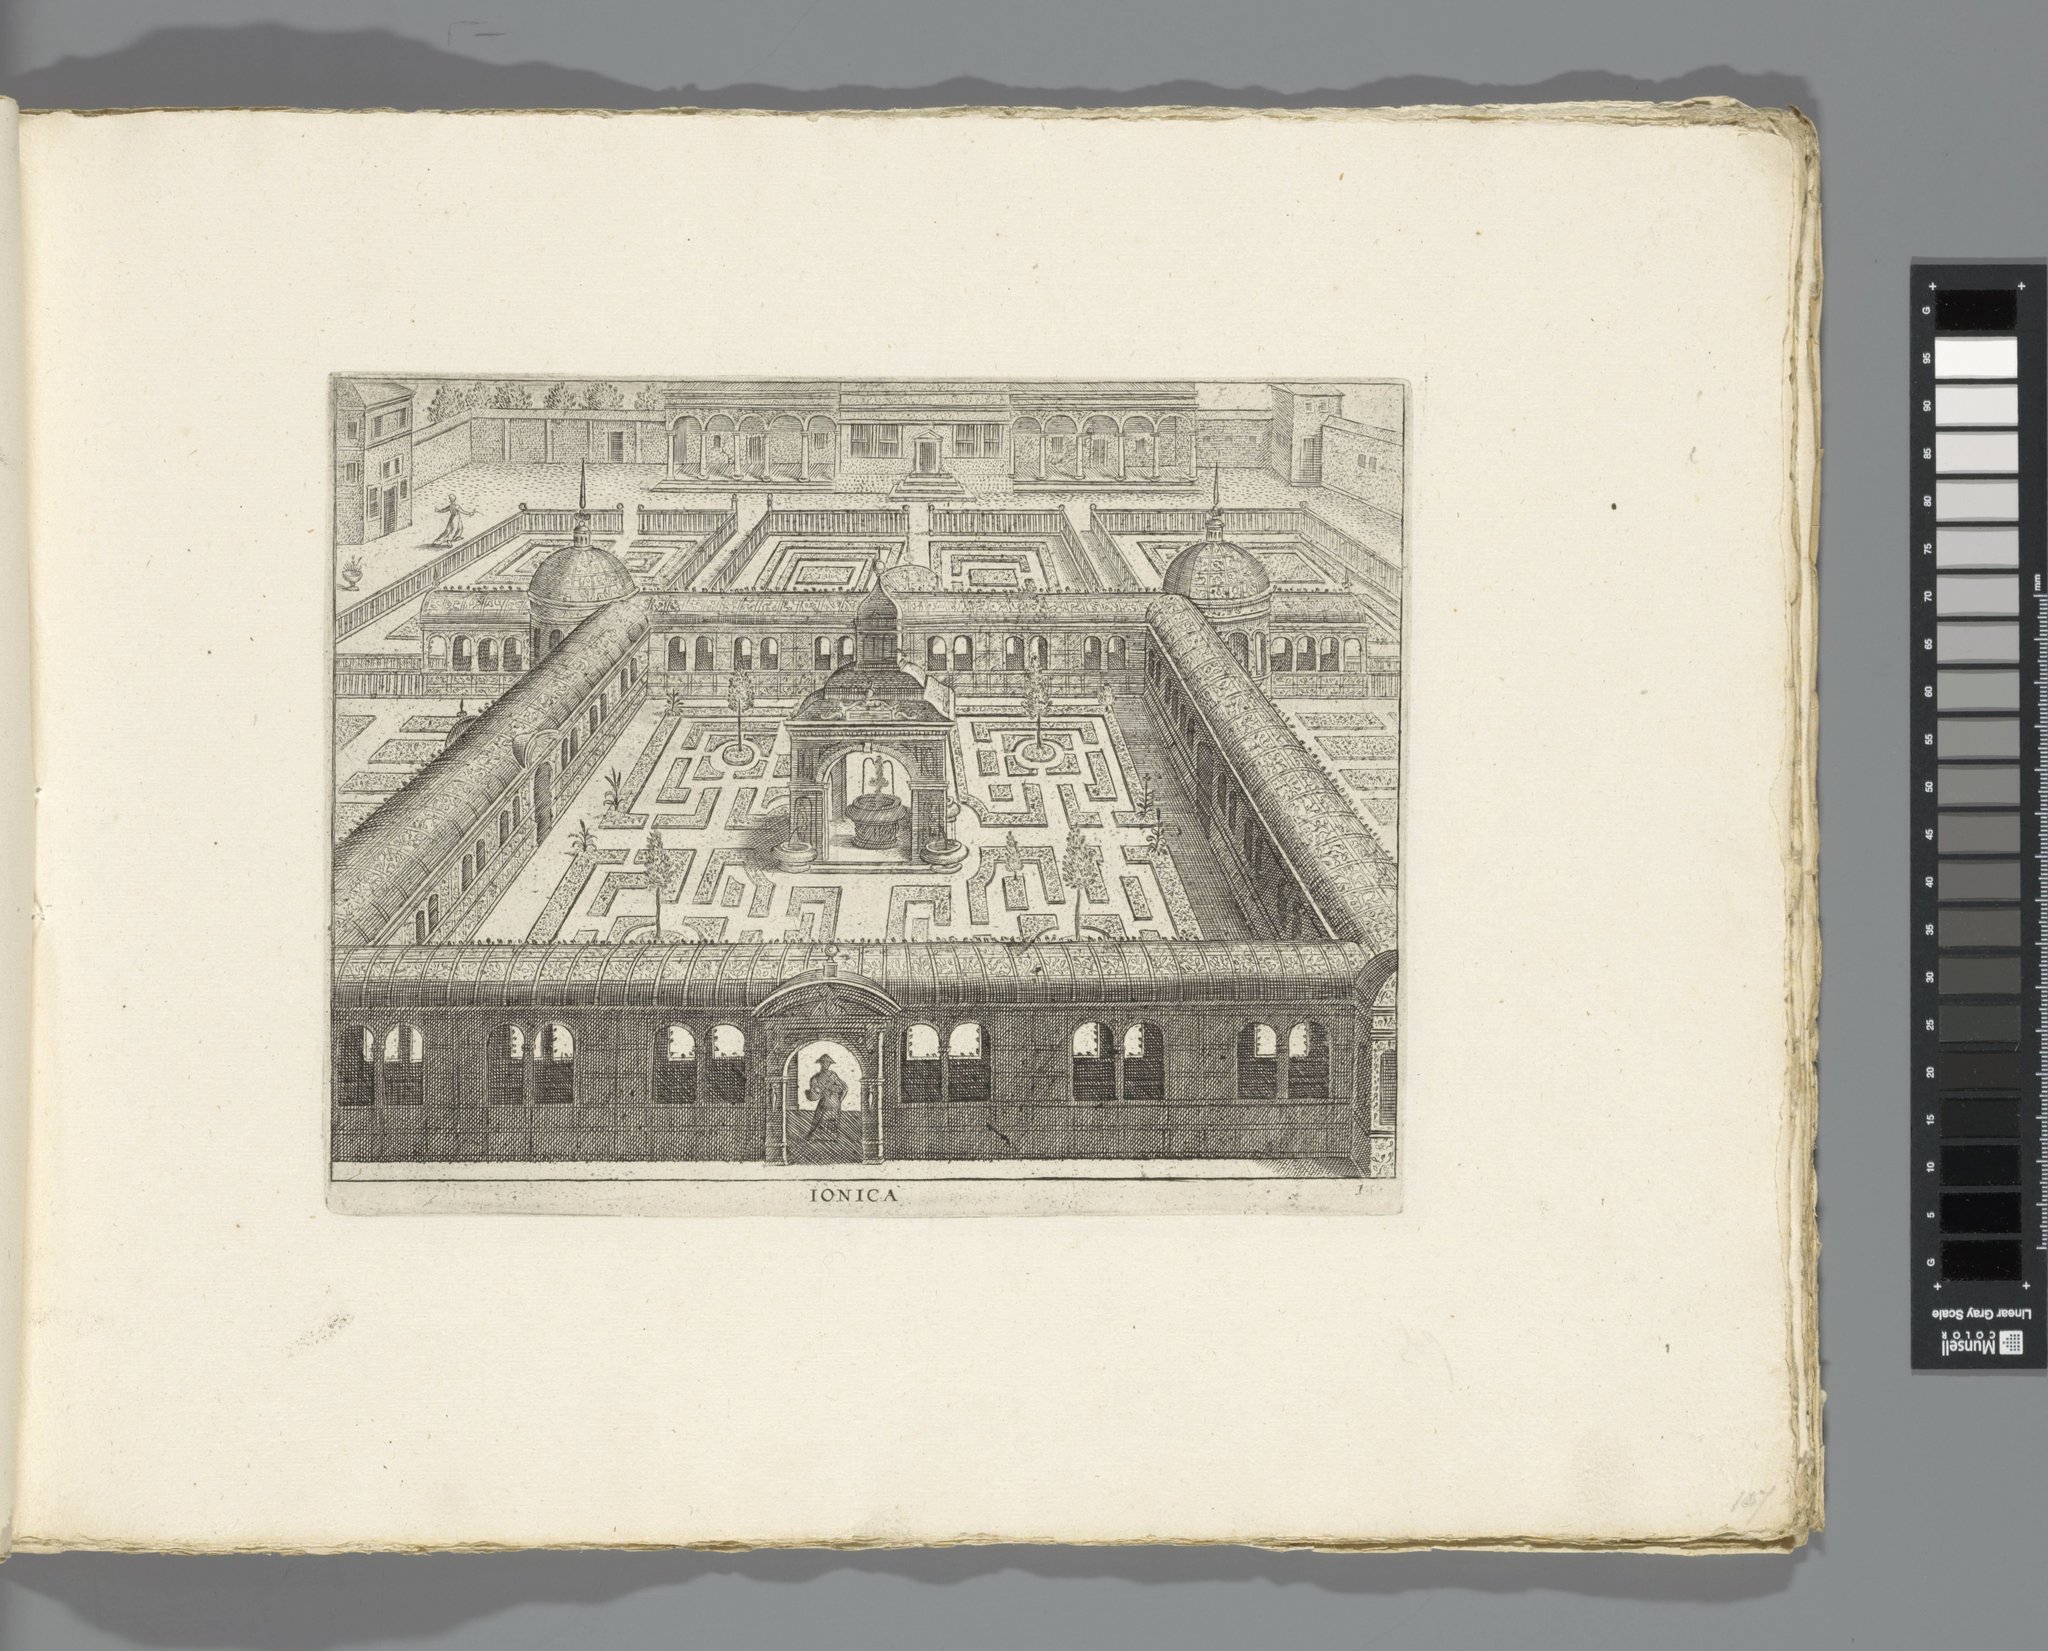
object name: print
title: Hortorum Viridariorumque (...)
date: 1583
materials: paper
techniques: etching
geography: antwerp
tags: garden, french or architectonic garden; formal garden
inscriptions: collector's mark: Lugt 2228, collector's mark: Lugt 2760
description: De serie ‘Hortorum Viridariorumque’ van Vredeman de Vries (Hollstein Dutch 470-490) is in deze editie van de serie door uitgever Joannes Galle ( en eerder door zijn voorganger Theodoor Galle) aangevuld met de serie ‘Tuinen’ van Vredeman de Vries (Hollstein Dutch 508-515) en met twee prenten van Pieter van der Borcht (I) (New Hollstein Dutch 161-162). De prenten zijn genummerd: 1-30. Origineel hoort bij deze editie van de serie, uitgegeven door Joannes Galle, nog een prent van Van der Borcht met nummer 31, maar deze prent ontbreekt in deze serie in de collectie van het Rijksmuseum.